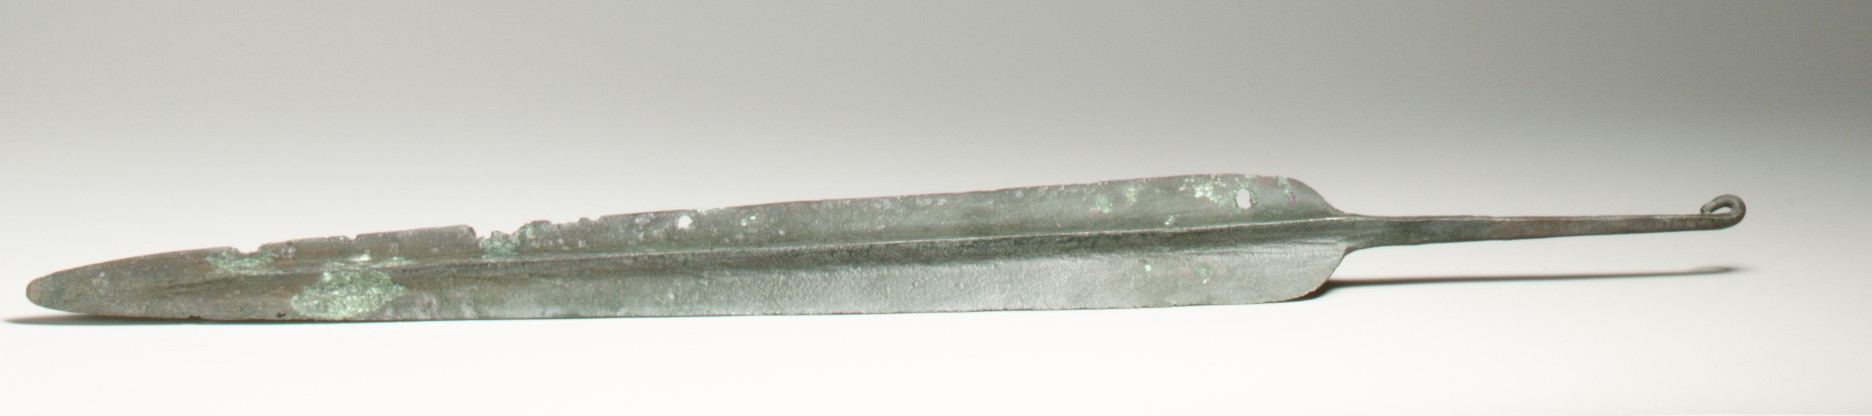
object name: dagger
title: Copper alloy spearhead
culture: cypriot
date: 2500-2000 BCE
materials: bronze